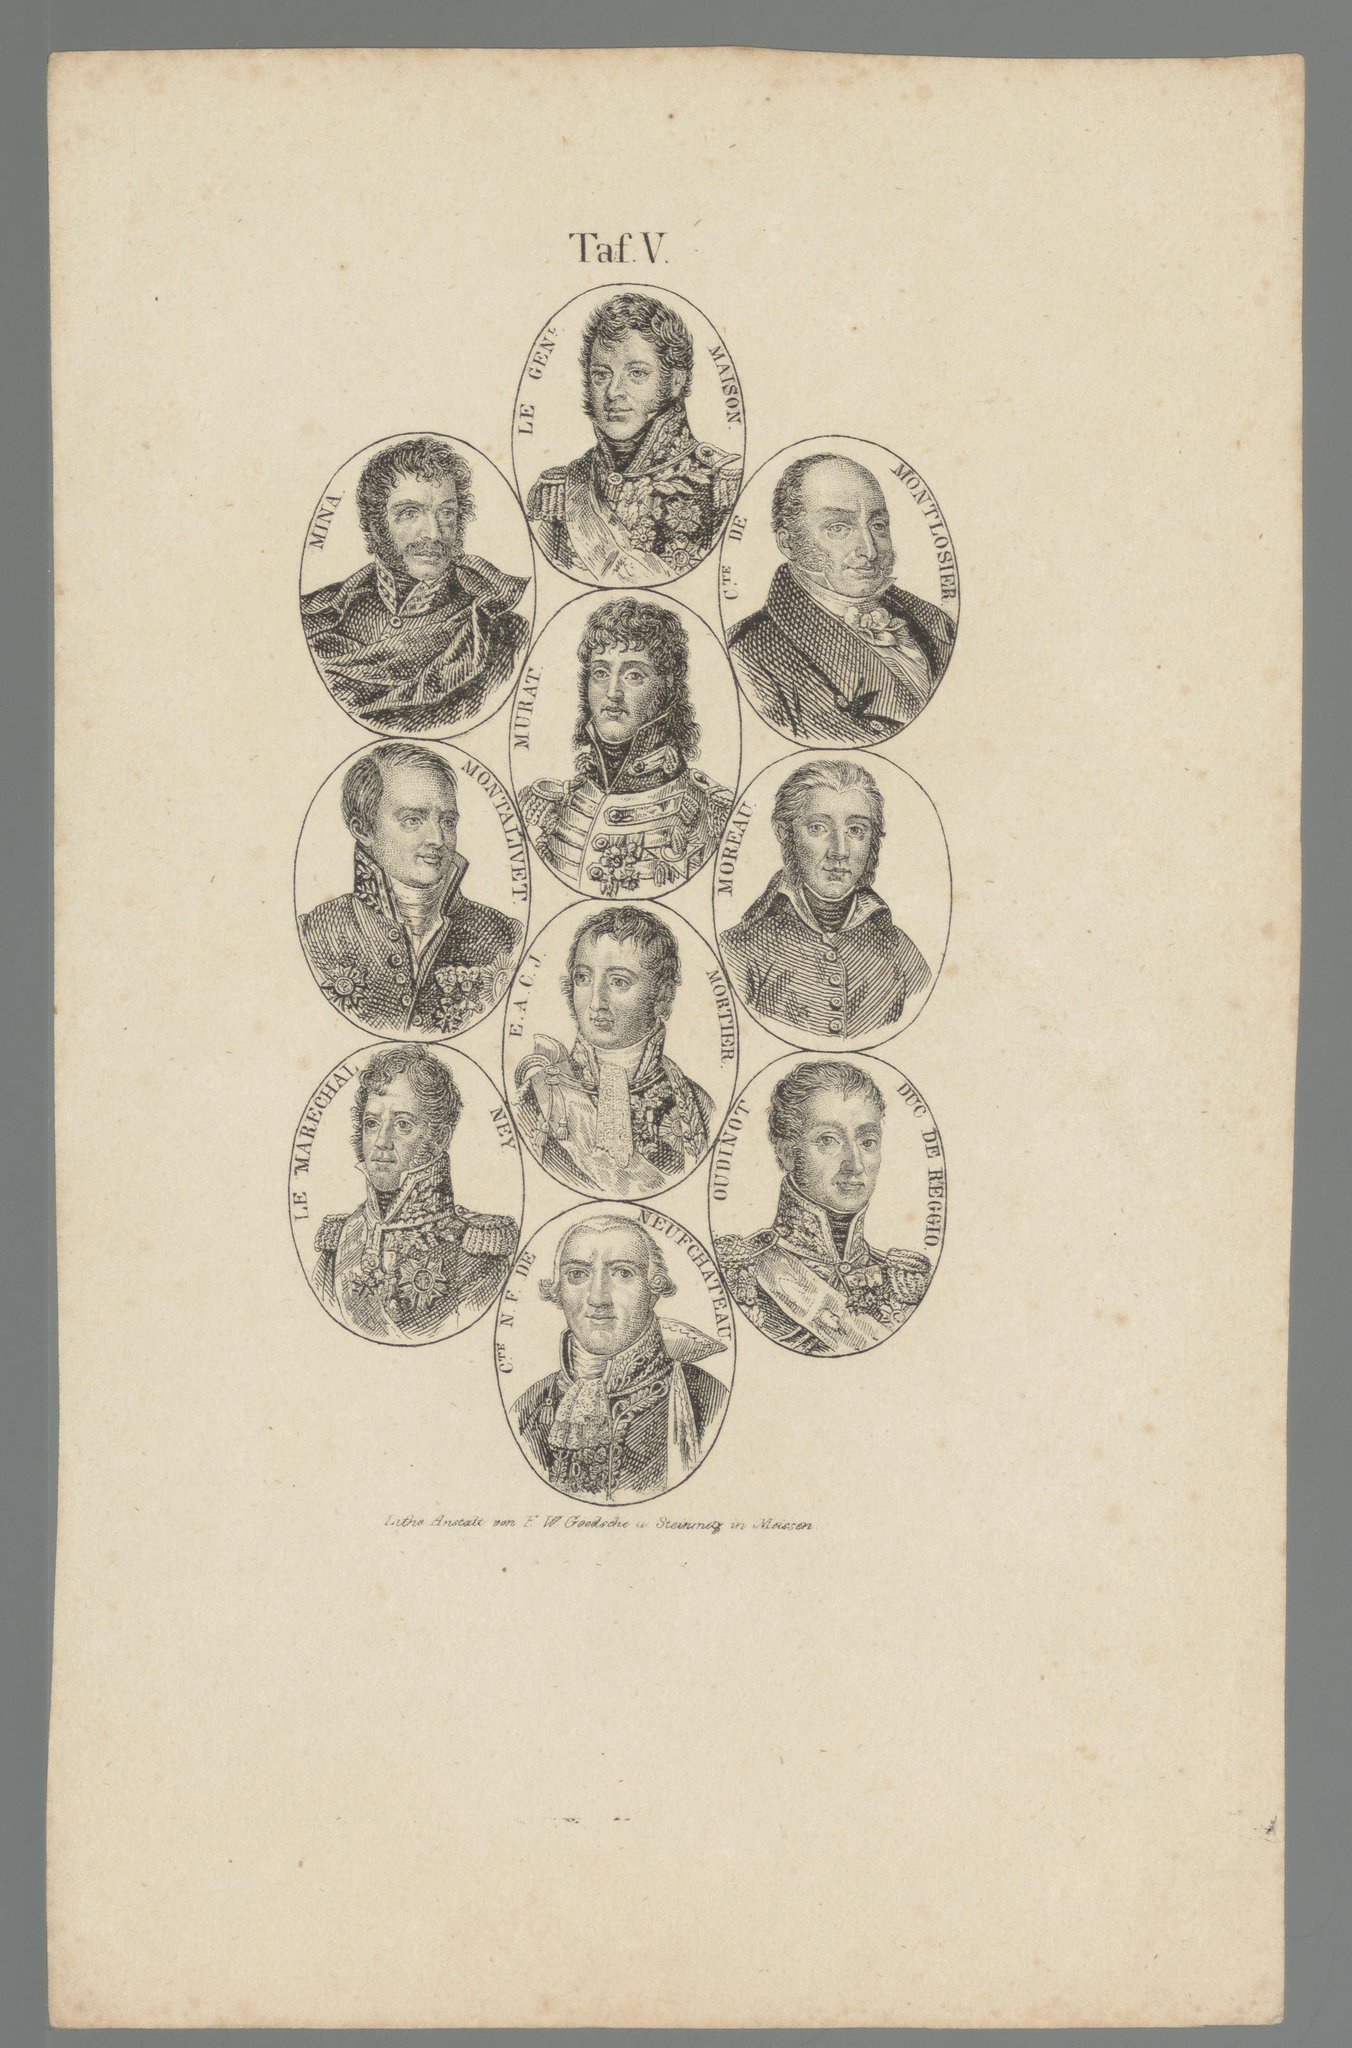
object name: print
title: Tien portretten van militairen in de Napoleontische tijd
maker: Anonymous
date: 1800-1850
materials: paper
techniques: lithograph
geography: meissen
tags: politician, pizzo, paris, historical persons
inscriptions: collector's mark: Lugt 2228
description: Prent maakt deel uit van een serie met portretten. Over deze serie is verder niets bekend. Het betreft voornamelijk portretten van Franse militairen, politici en edellieden die veelal betrokken waren bij de Franse Revolutie en de Napoleontische oorlogen.